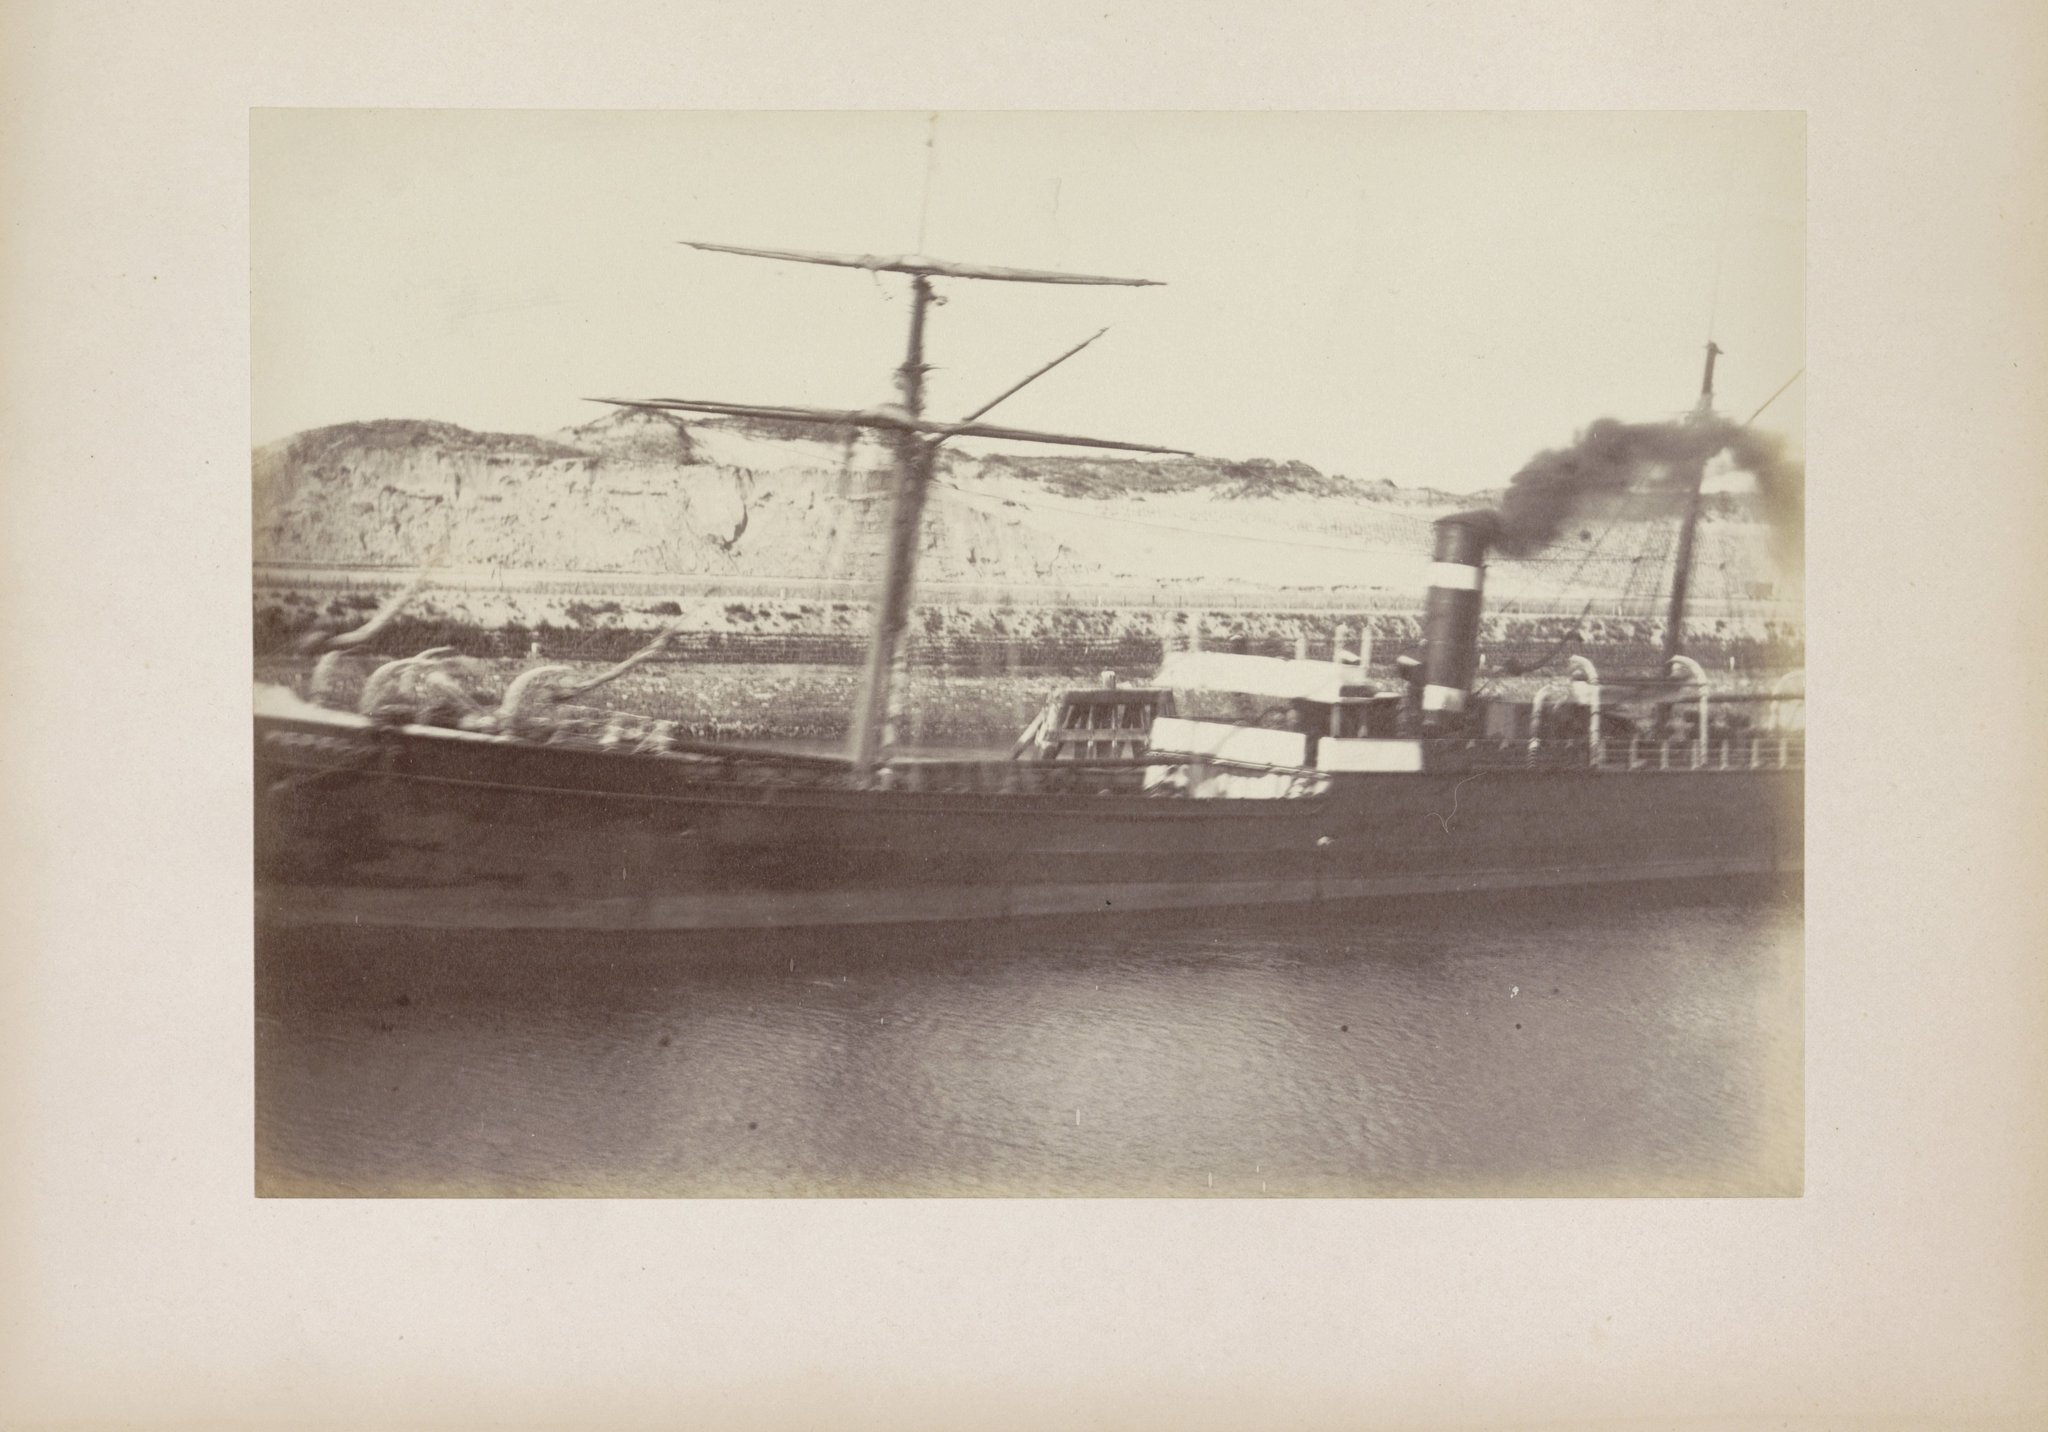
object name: photograph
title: Vrachtschip in het Noordzeekanaal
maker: Anonymous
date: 1885-1900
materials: paper, photographic support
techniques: albumen print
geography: france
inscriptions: annotation: ‘Hollande’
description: Vrachtschip vaart op stoom door het Noordzeekanaal, Nederland. Op de achtergrond de duinen.